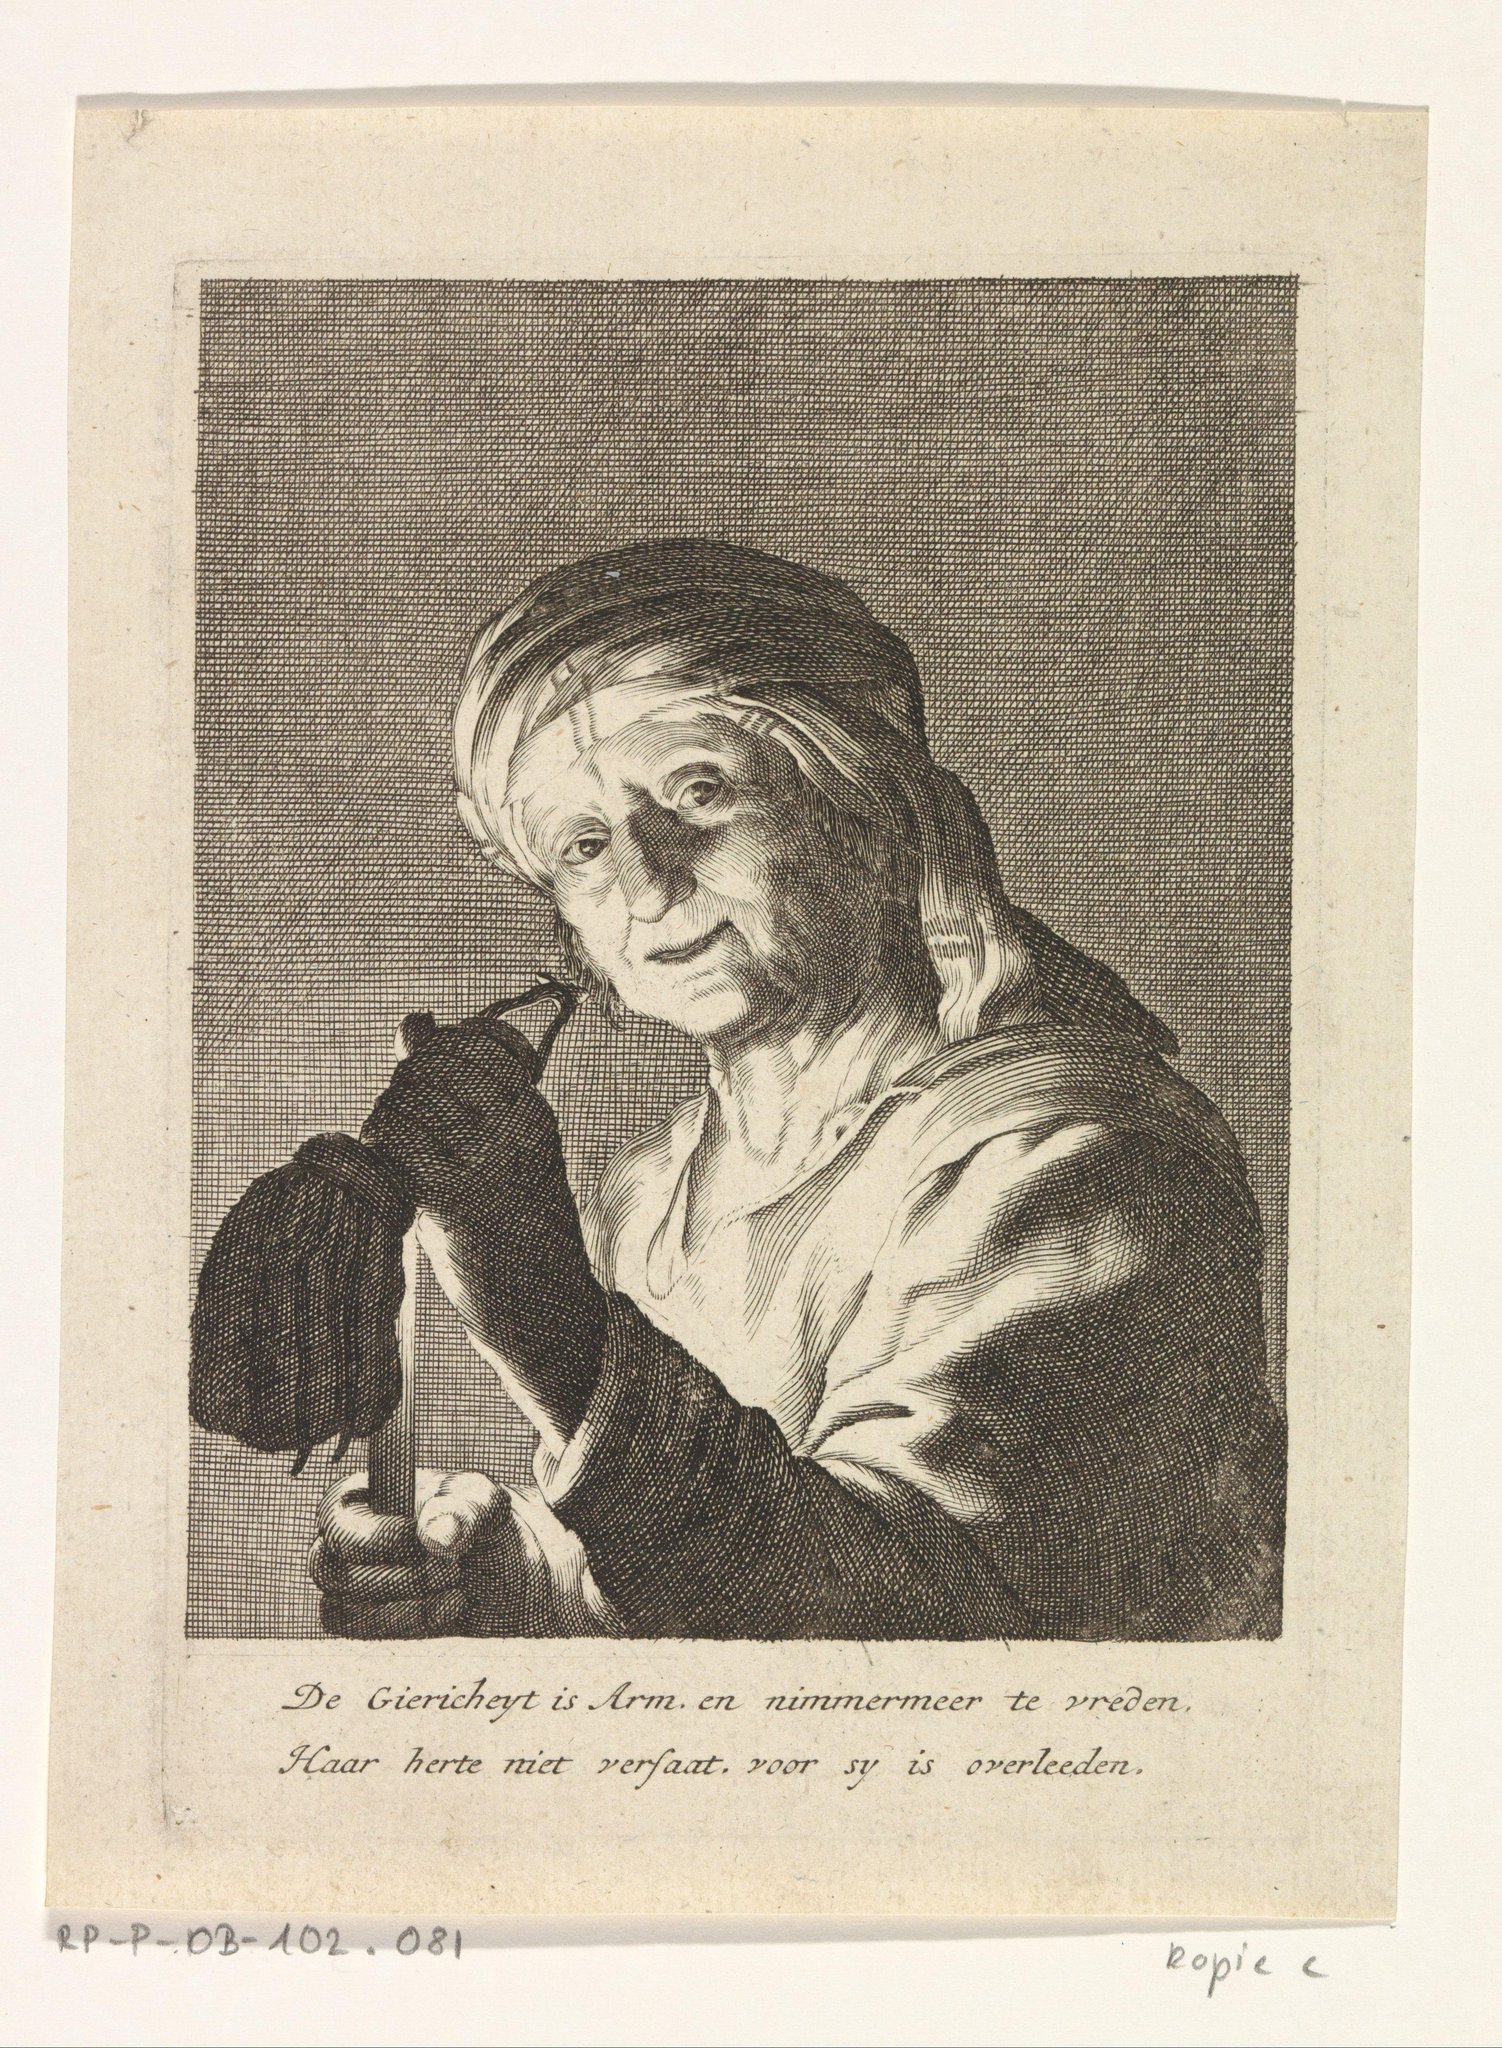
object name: print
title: Vrouw met lege beurs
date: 1625-1675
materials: paper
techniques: etching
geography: utrecht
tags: purse, money-bag, covetousness; 'avaritia' (ripa) ~ personification of one of the seven deadly sins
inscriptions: collector's mark: Lugt 2028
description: Een oude vrouw houdt in het schijnsel van een kaars een lege geldbeurs op. Met onderschrift: "De Giericheyt is Arm. en nimmermeer te vreden / Haar herte niet verslaat, voor sy is overleden".